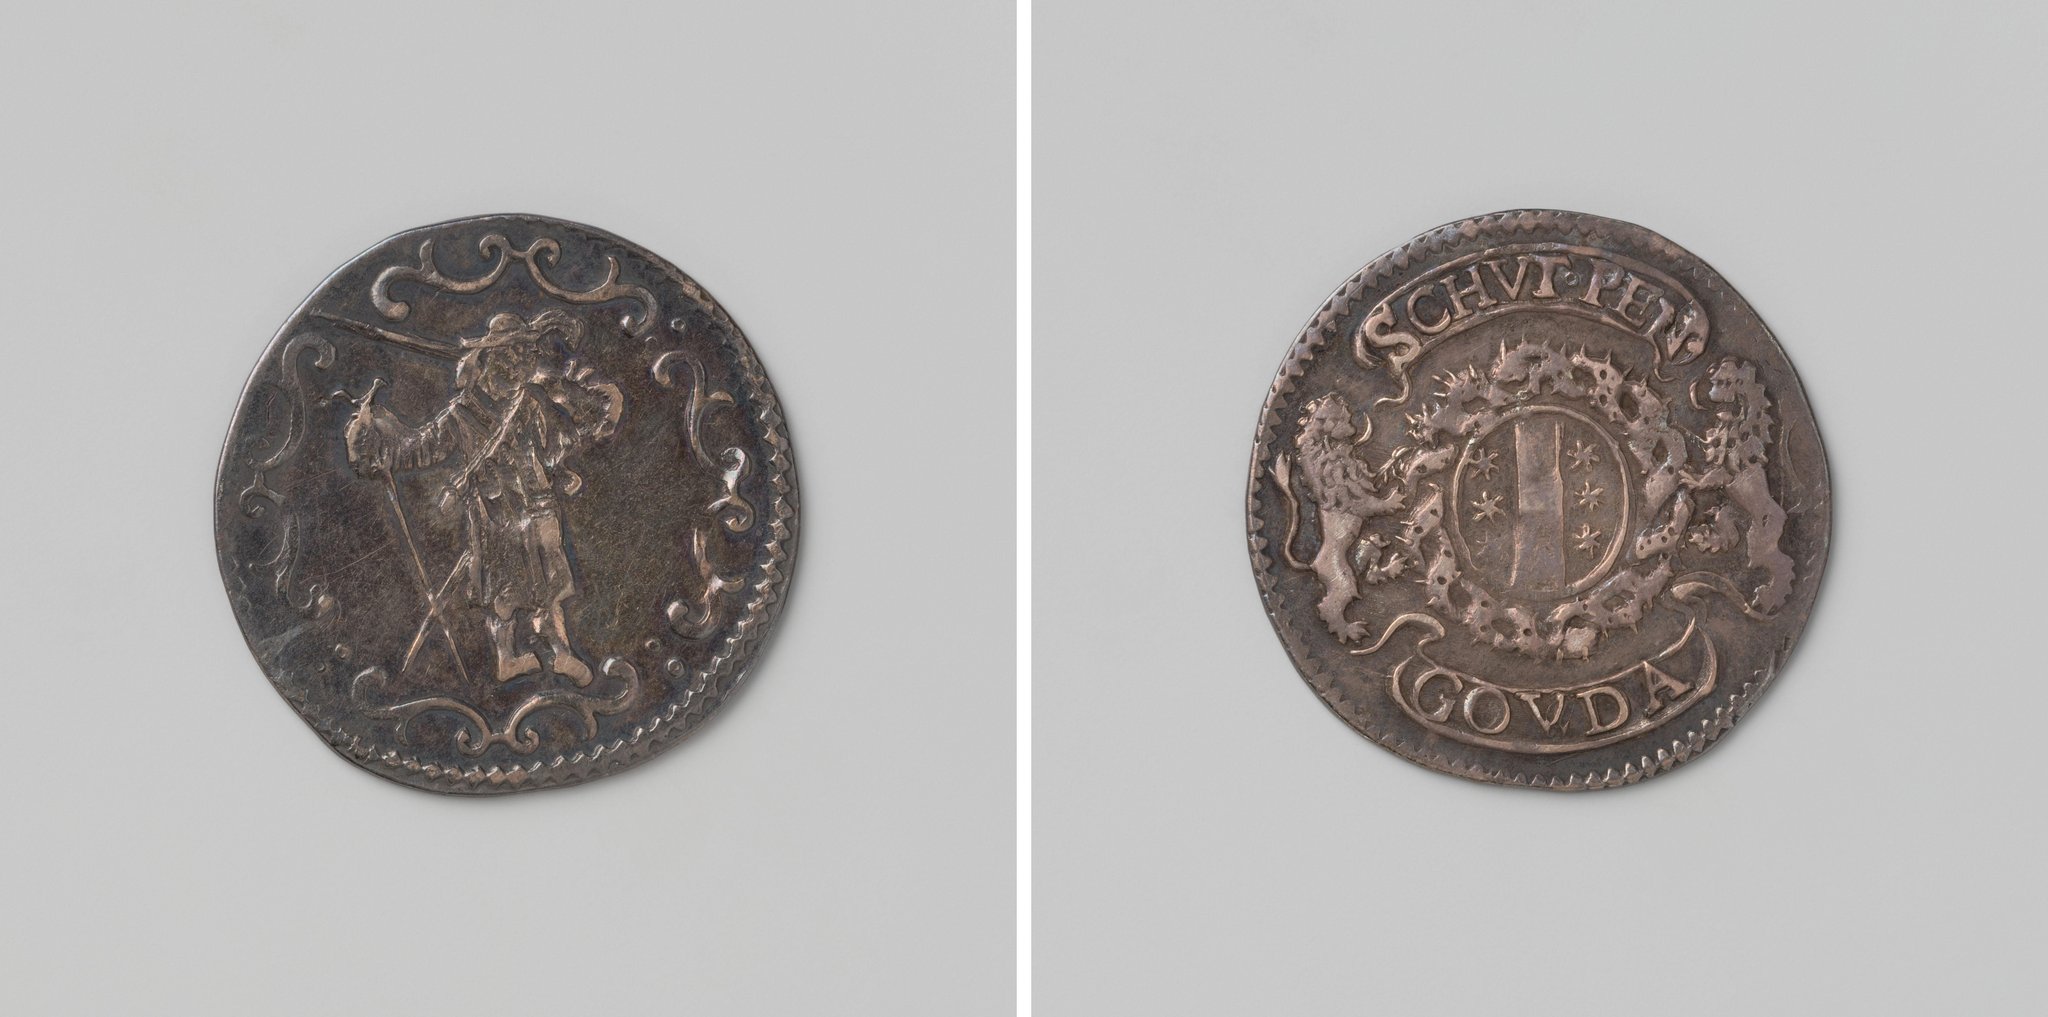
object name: marksman medal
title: Schutterij van Gouda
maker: Anonymous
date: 1600-1700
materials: silver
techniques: striking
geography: gouda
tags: gouda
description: Zilveren penning. Voorzijde: schutter met geweer over linker schouder en vork in rechterhand binnen siermotief. Keerzijde: gekroond wapenschild binnen omschrift op wimpels